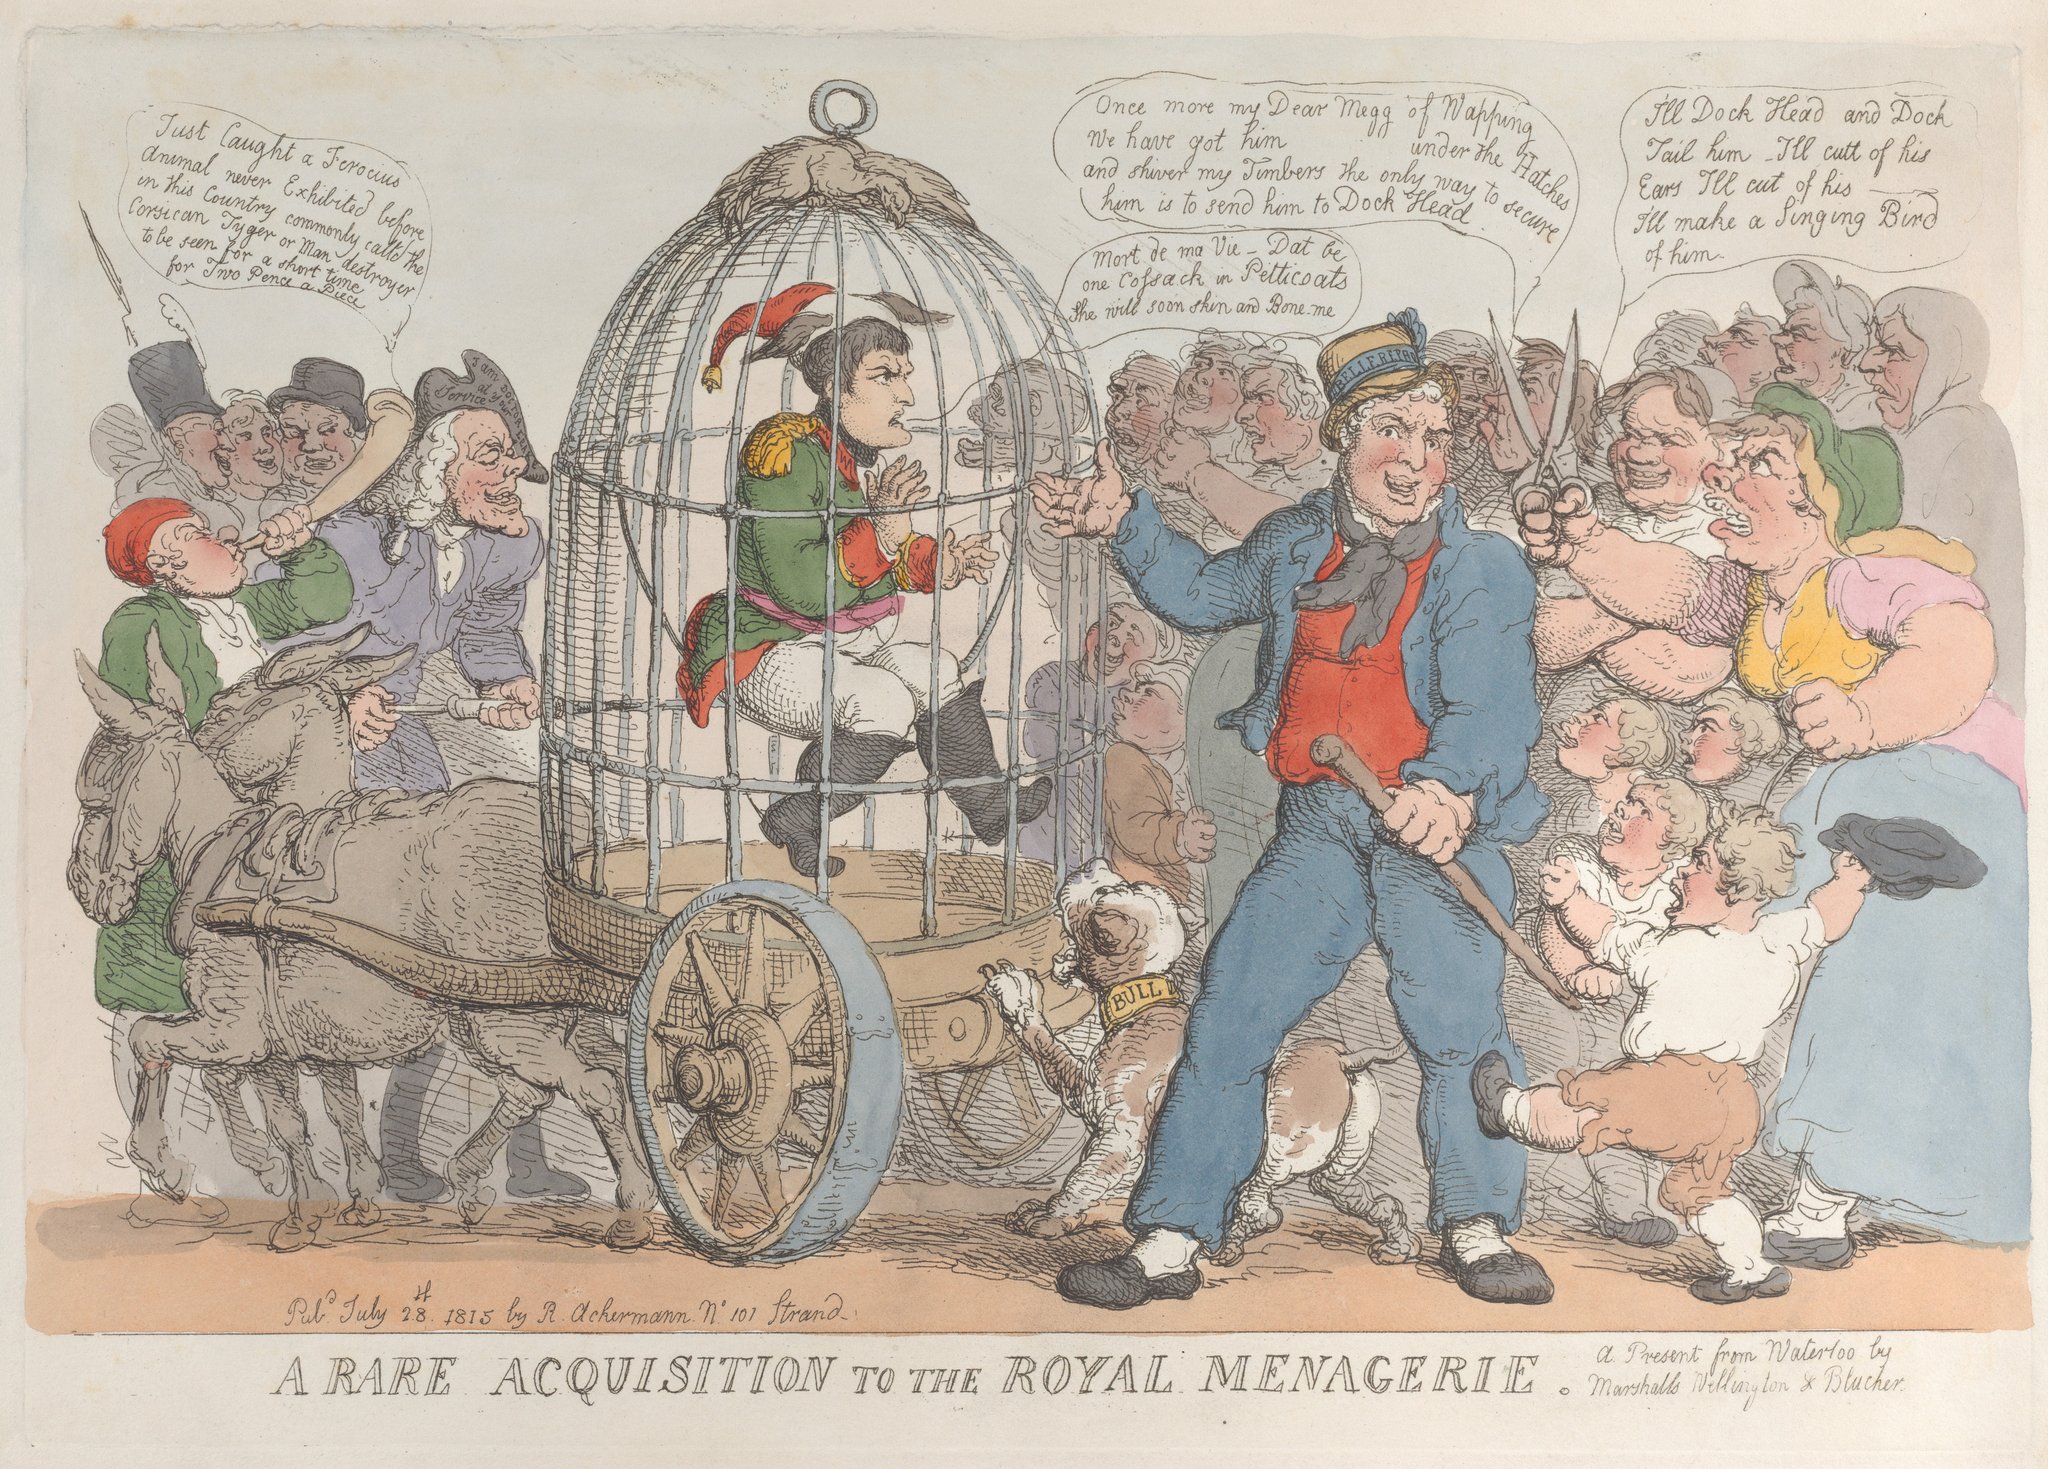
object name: print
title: A Rare Acquisition to the Royal Menagerie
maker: thomas rowlandson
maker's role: artist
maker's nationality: british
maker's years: 1757-1827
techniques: etching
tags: satire,napoleon i,men,women,dogs,politics